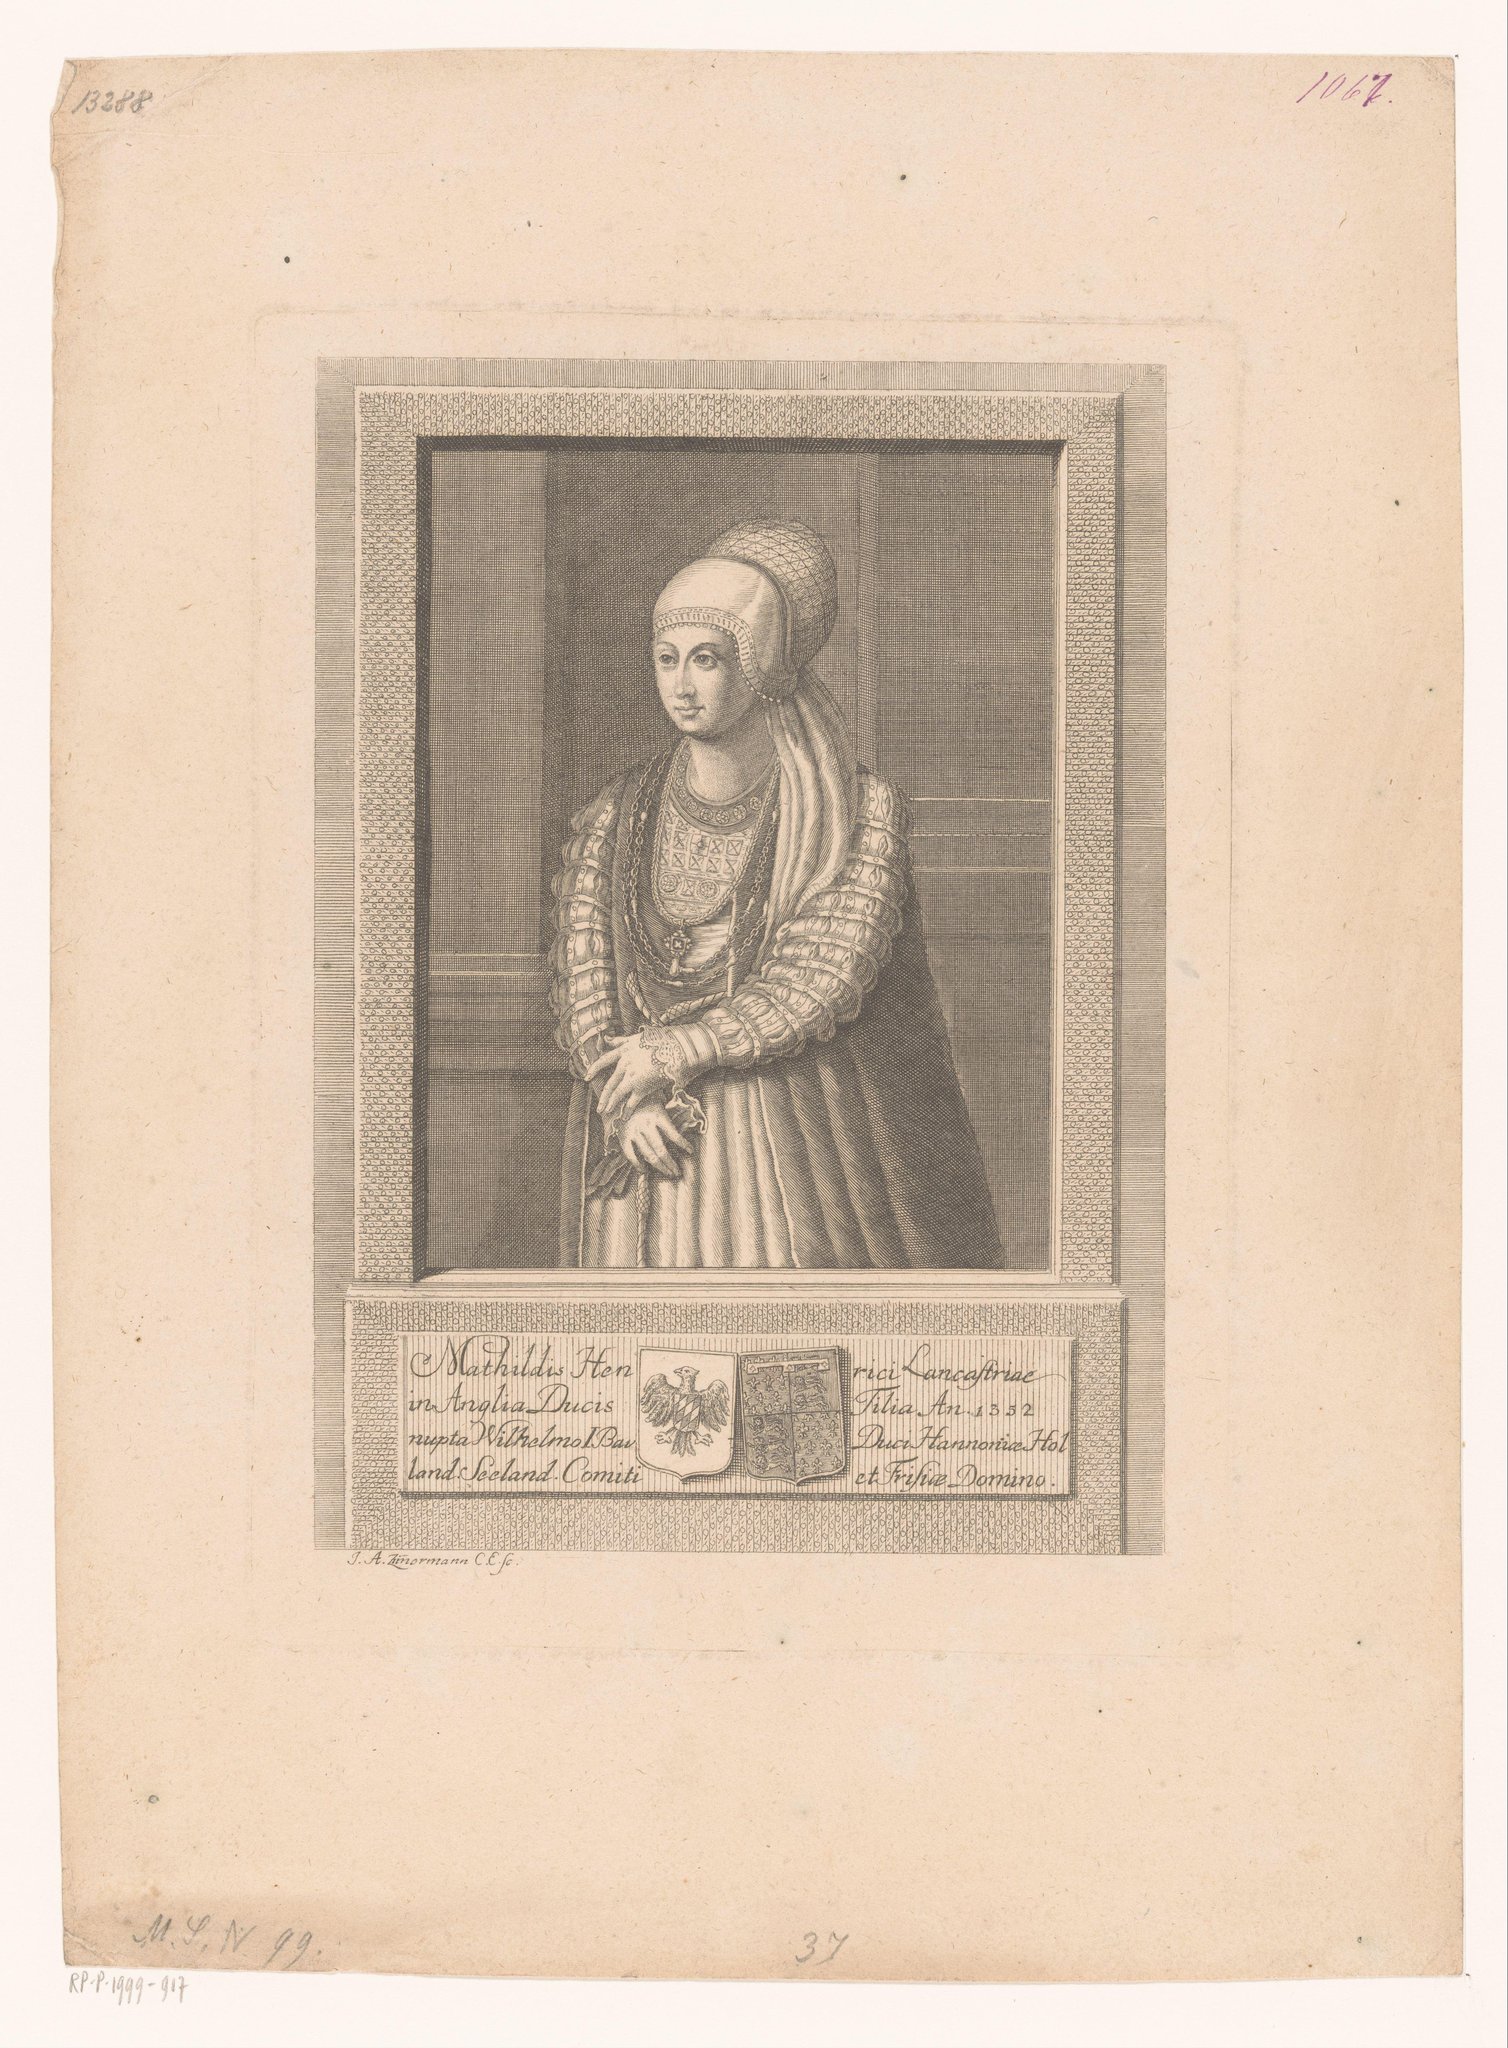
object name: print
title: Portret van Machteld van Lancaster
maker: joseph anton zimmermann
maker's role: draughtsman, print maker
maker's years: 1705-1797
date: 1773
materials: paper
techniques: engraving, etching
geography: germany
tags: historical persons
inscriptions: collector's mark: Lugt 1238, collector's mark: Lugt 2228, collector's mark: Lugt 4100, collector's mark: Lugt 2760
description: Prent gebruikt voor de publicatie: Zimmermann, Joseph Anton. Series Imaginum Augustae Domus Boicae. München: s.n., 1773.